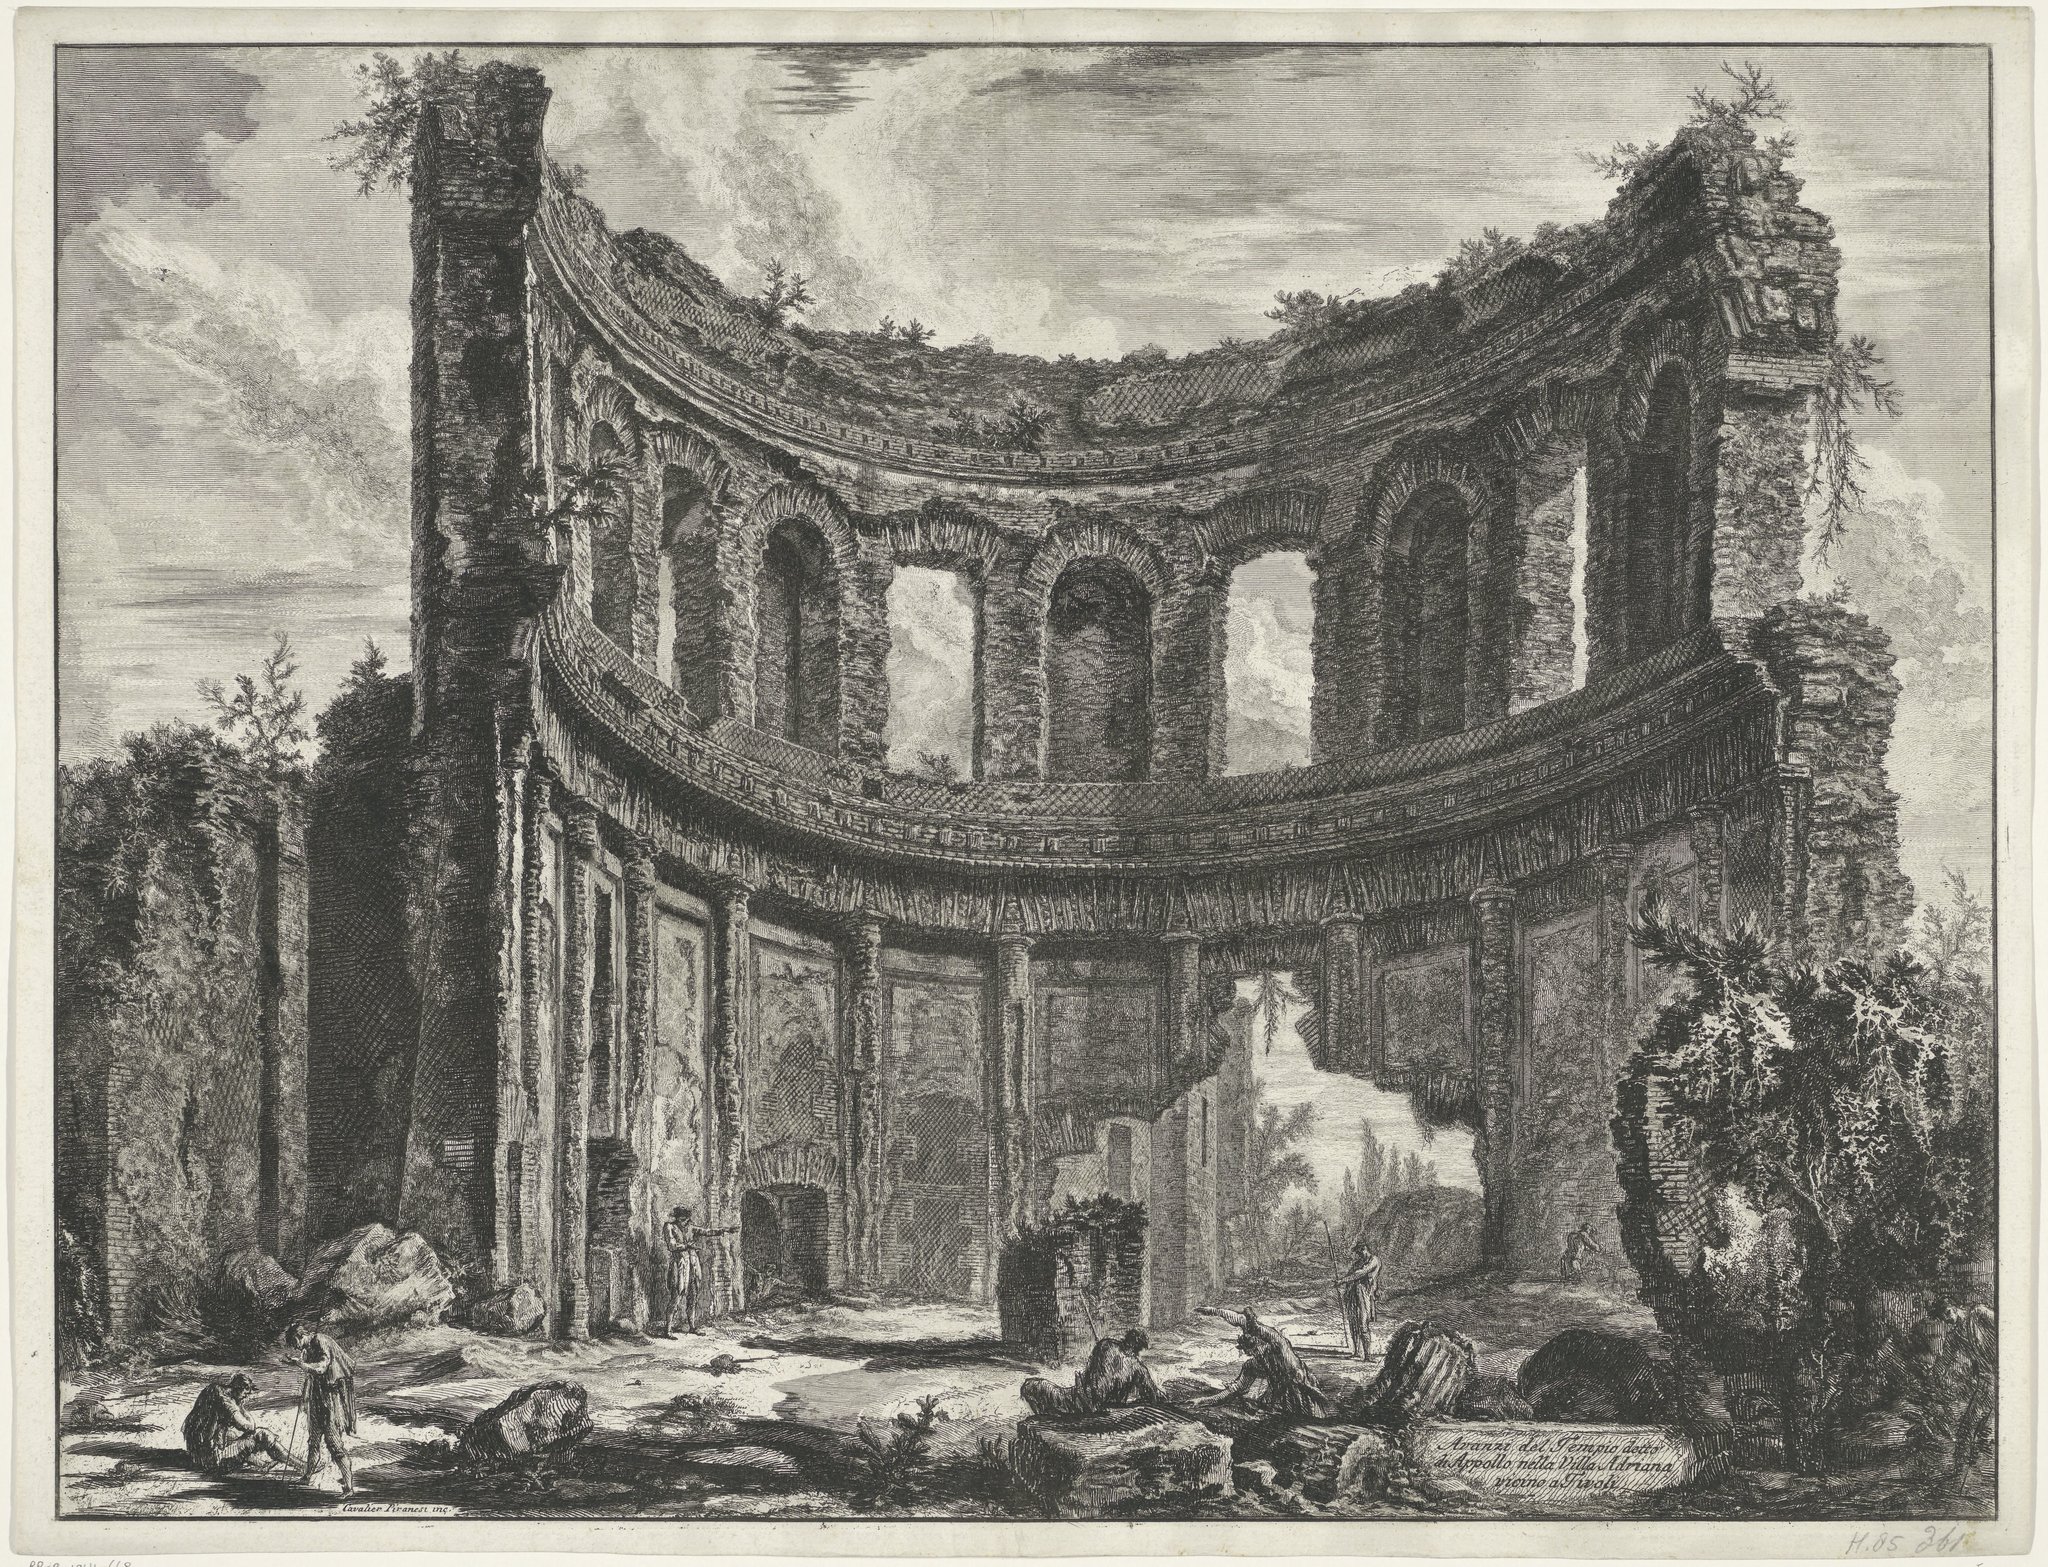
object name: print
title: Kleine paleis in Villa Adriana te Tivoli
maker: giovanni battista piranesi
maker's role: designer, draughtsman, print maker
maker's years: 1720-1778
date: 1748-1778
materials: paper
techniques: etching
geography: rome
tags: ruin of a building ~ architecture, landscape with ruins, villa, tivoli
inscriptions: collector's mark: Lugt 2228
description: Deze prent maakt deel uit van de serie 'Vedute di Roma'. Piranesi werkte aan deze 135 platen tellende serie tussen 1748 en zijn dood in 1778. Francesco Piranesi voegde later nog twee prenten toe aan de reeks van zijn vader.